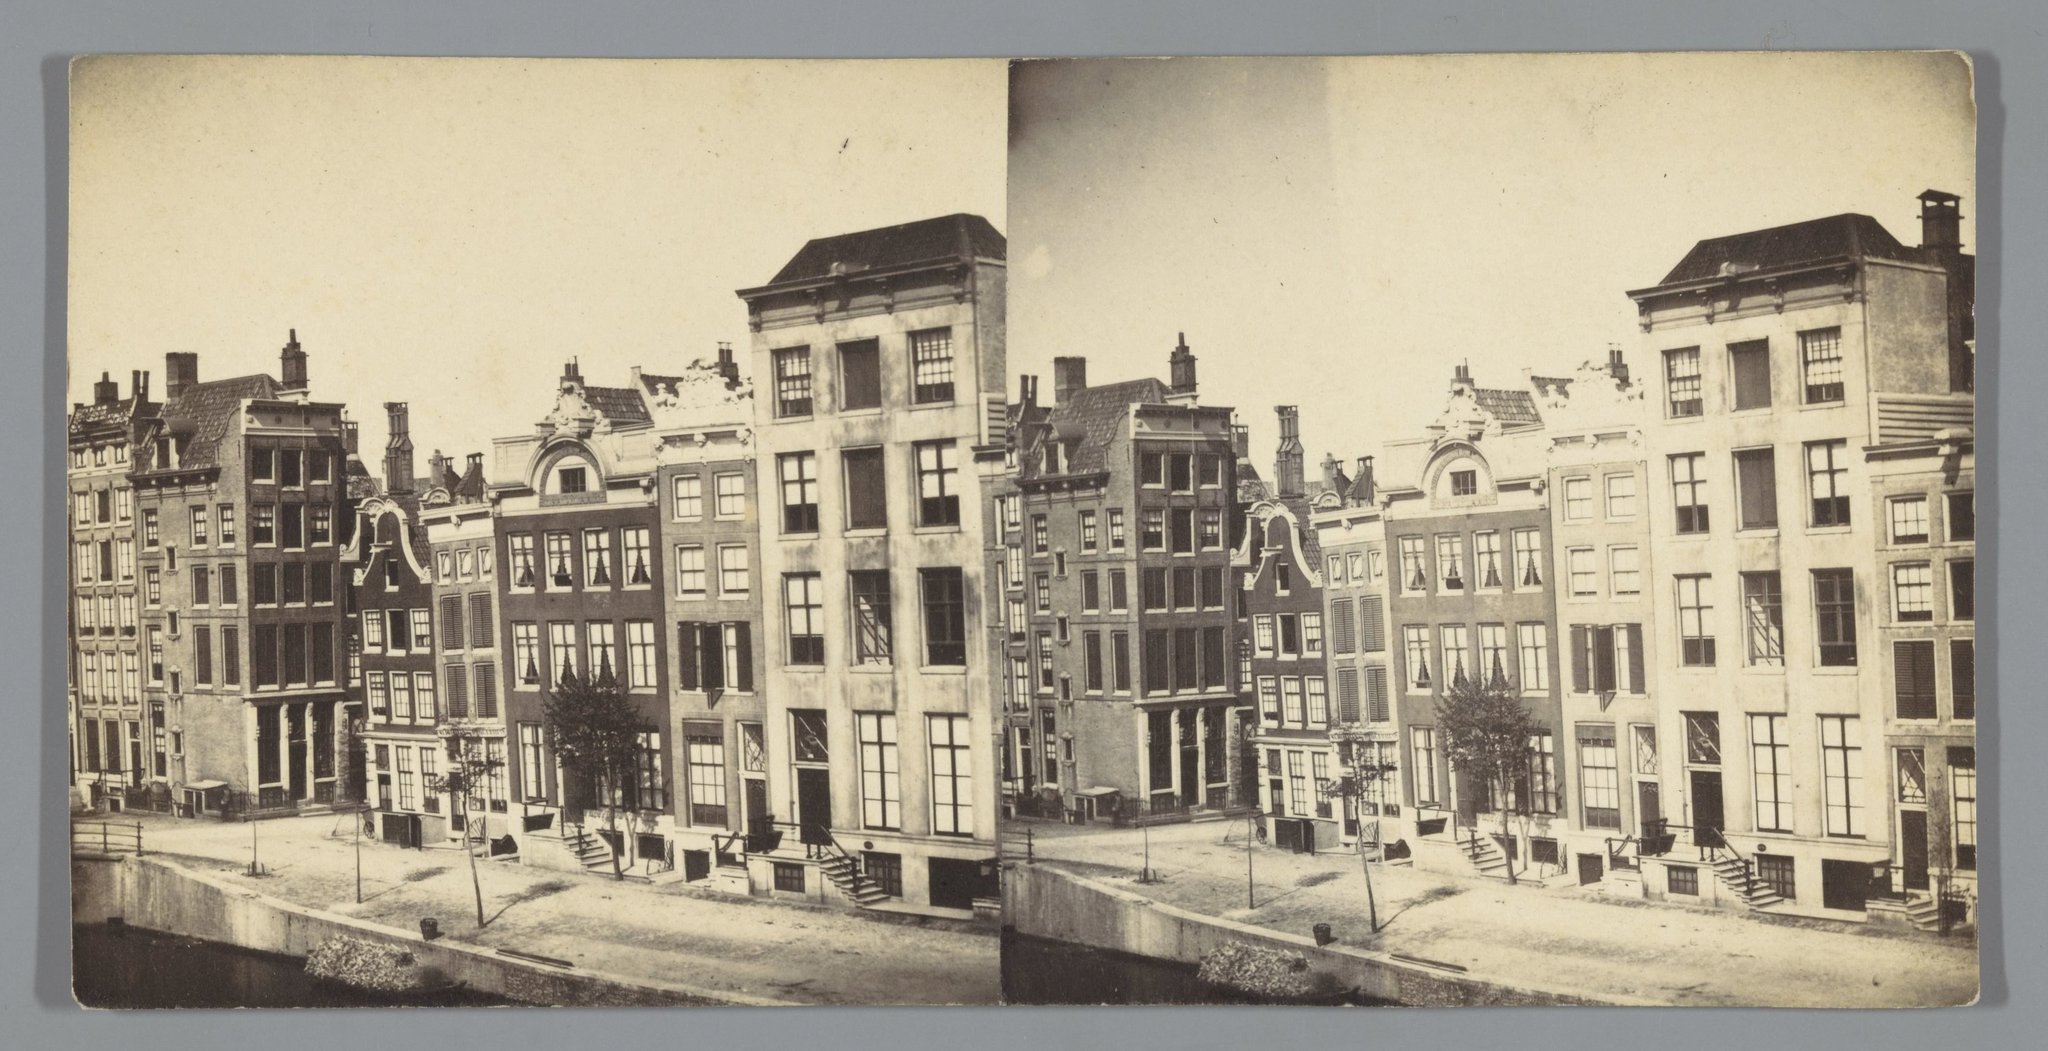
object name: stereograph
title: Keizersgracht op de hoek bij de Hartenstraat, Amsterdam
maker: Anonymous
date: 1898-1910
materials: paper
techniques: platinum process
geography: amsterdam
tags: canals, waters (in city)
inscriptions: inscription: ‘Amsterdam/ Keizersgracht hoek/ Hartenstraat’